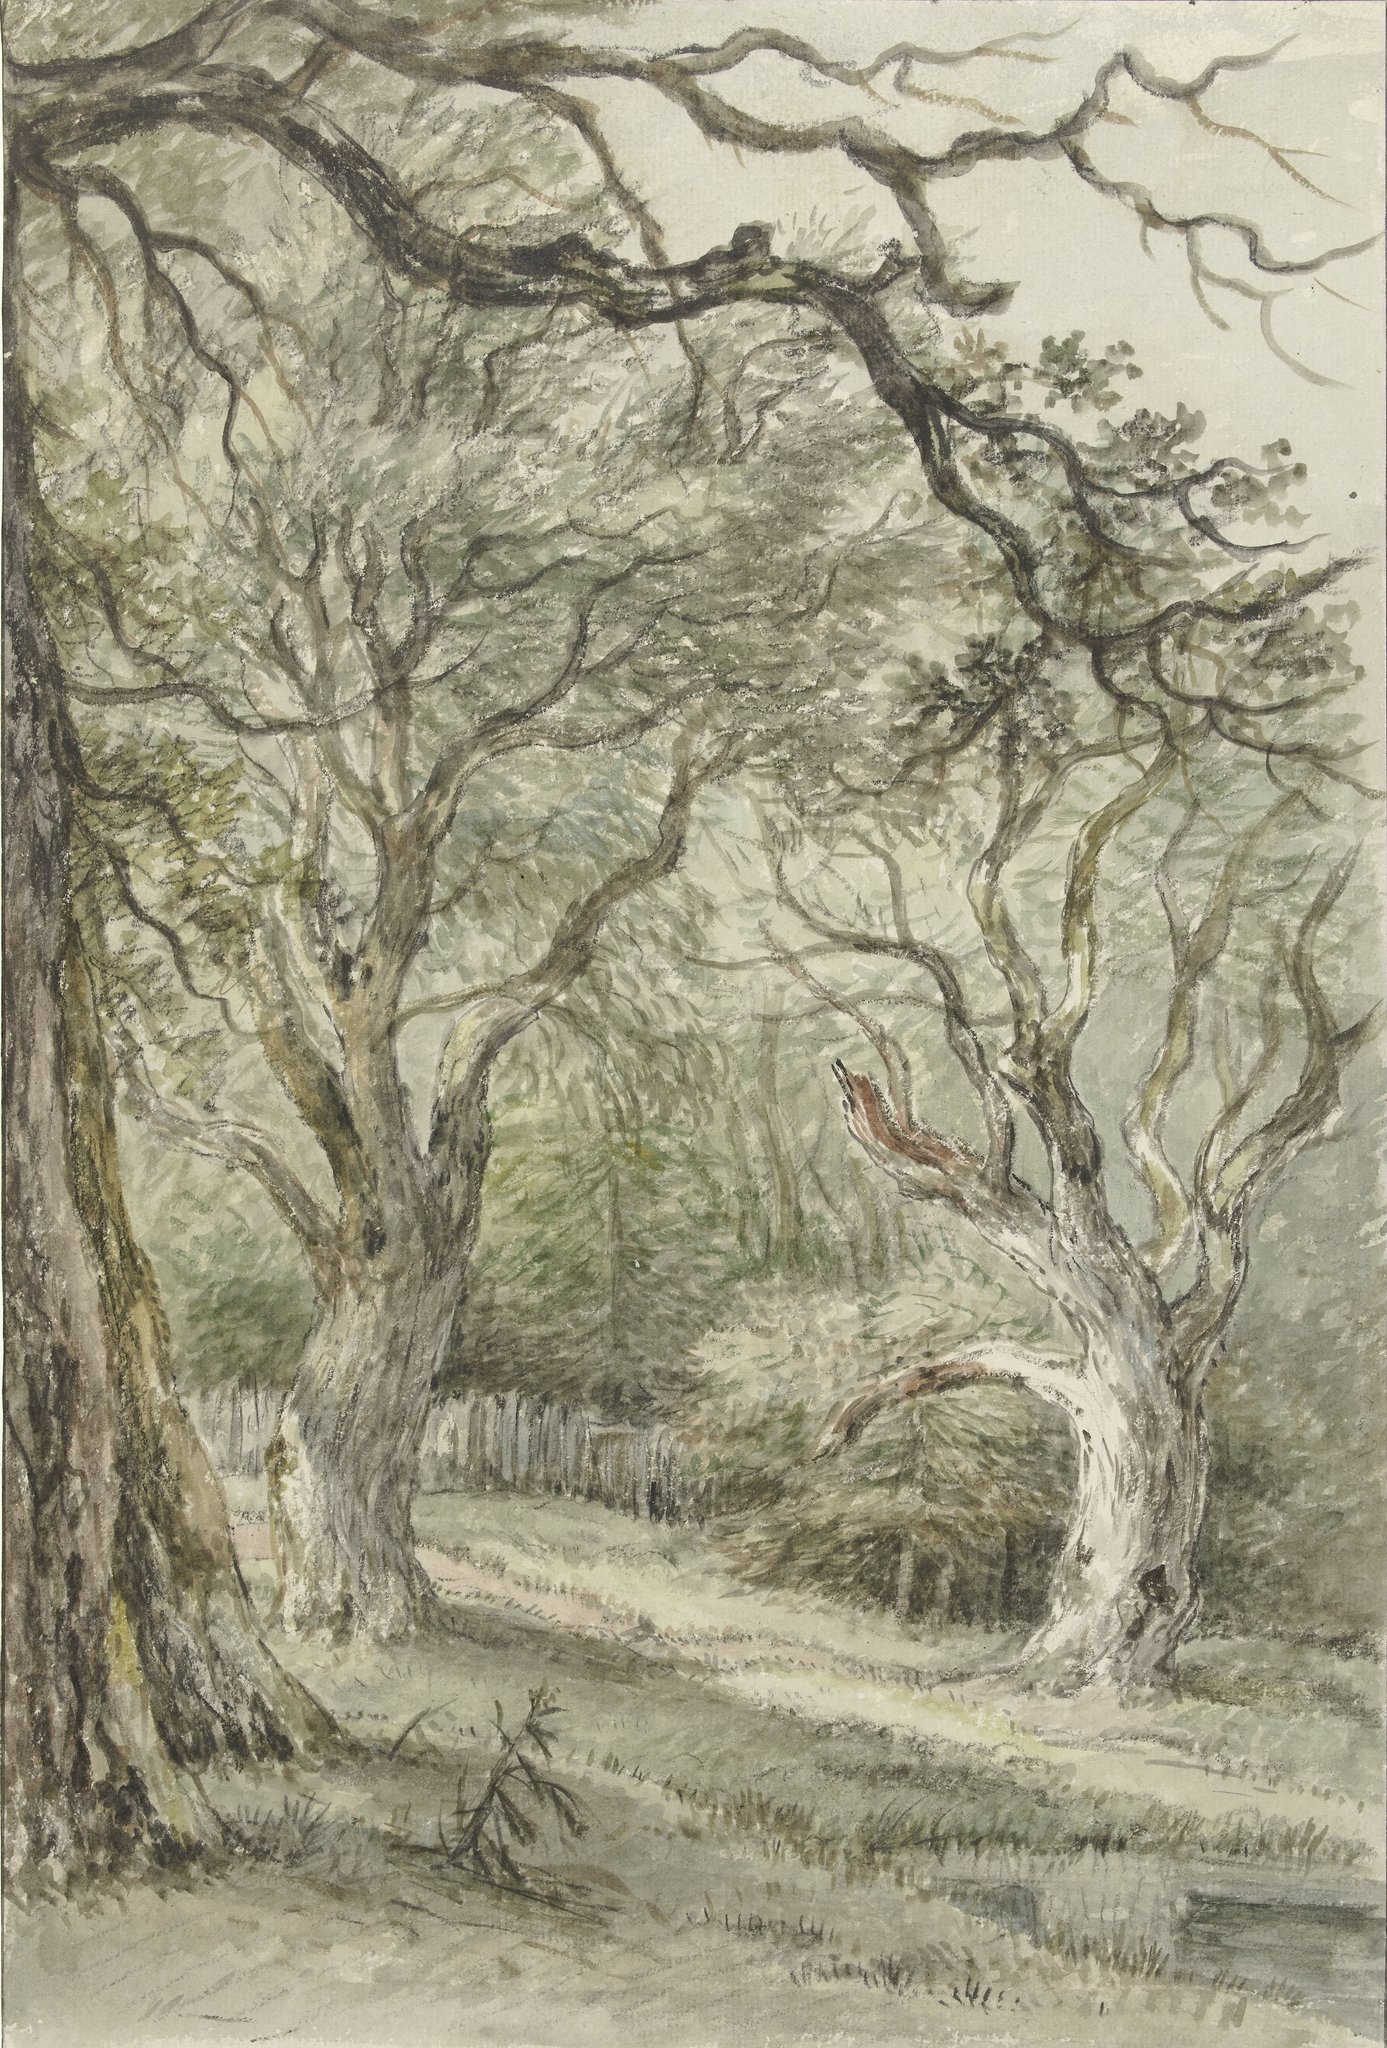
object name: watercolor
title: Bosgezicht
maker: jan hulswit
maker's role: draughtsman, painter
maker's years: 1766-1822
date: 1776-1822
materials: chalk, paper, watercolor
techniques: brush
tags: forest, wood